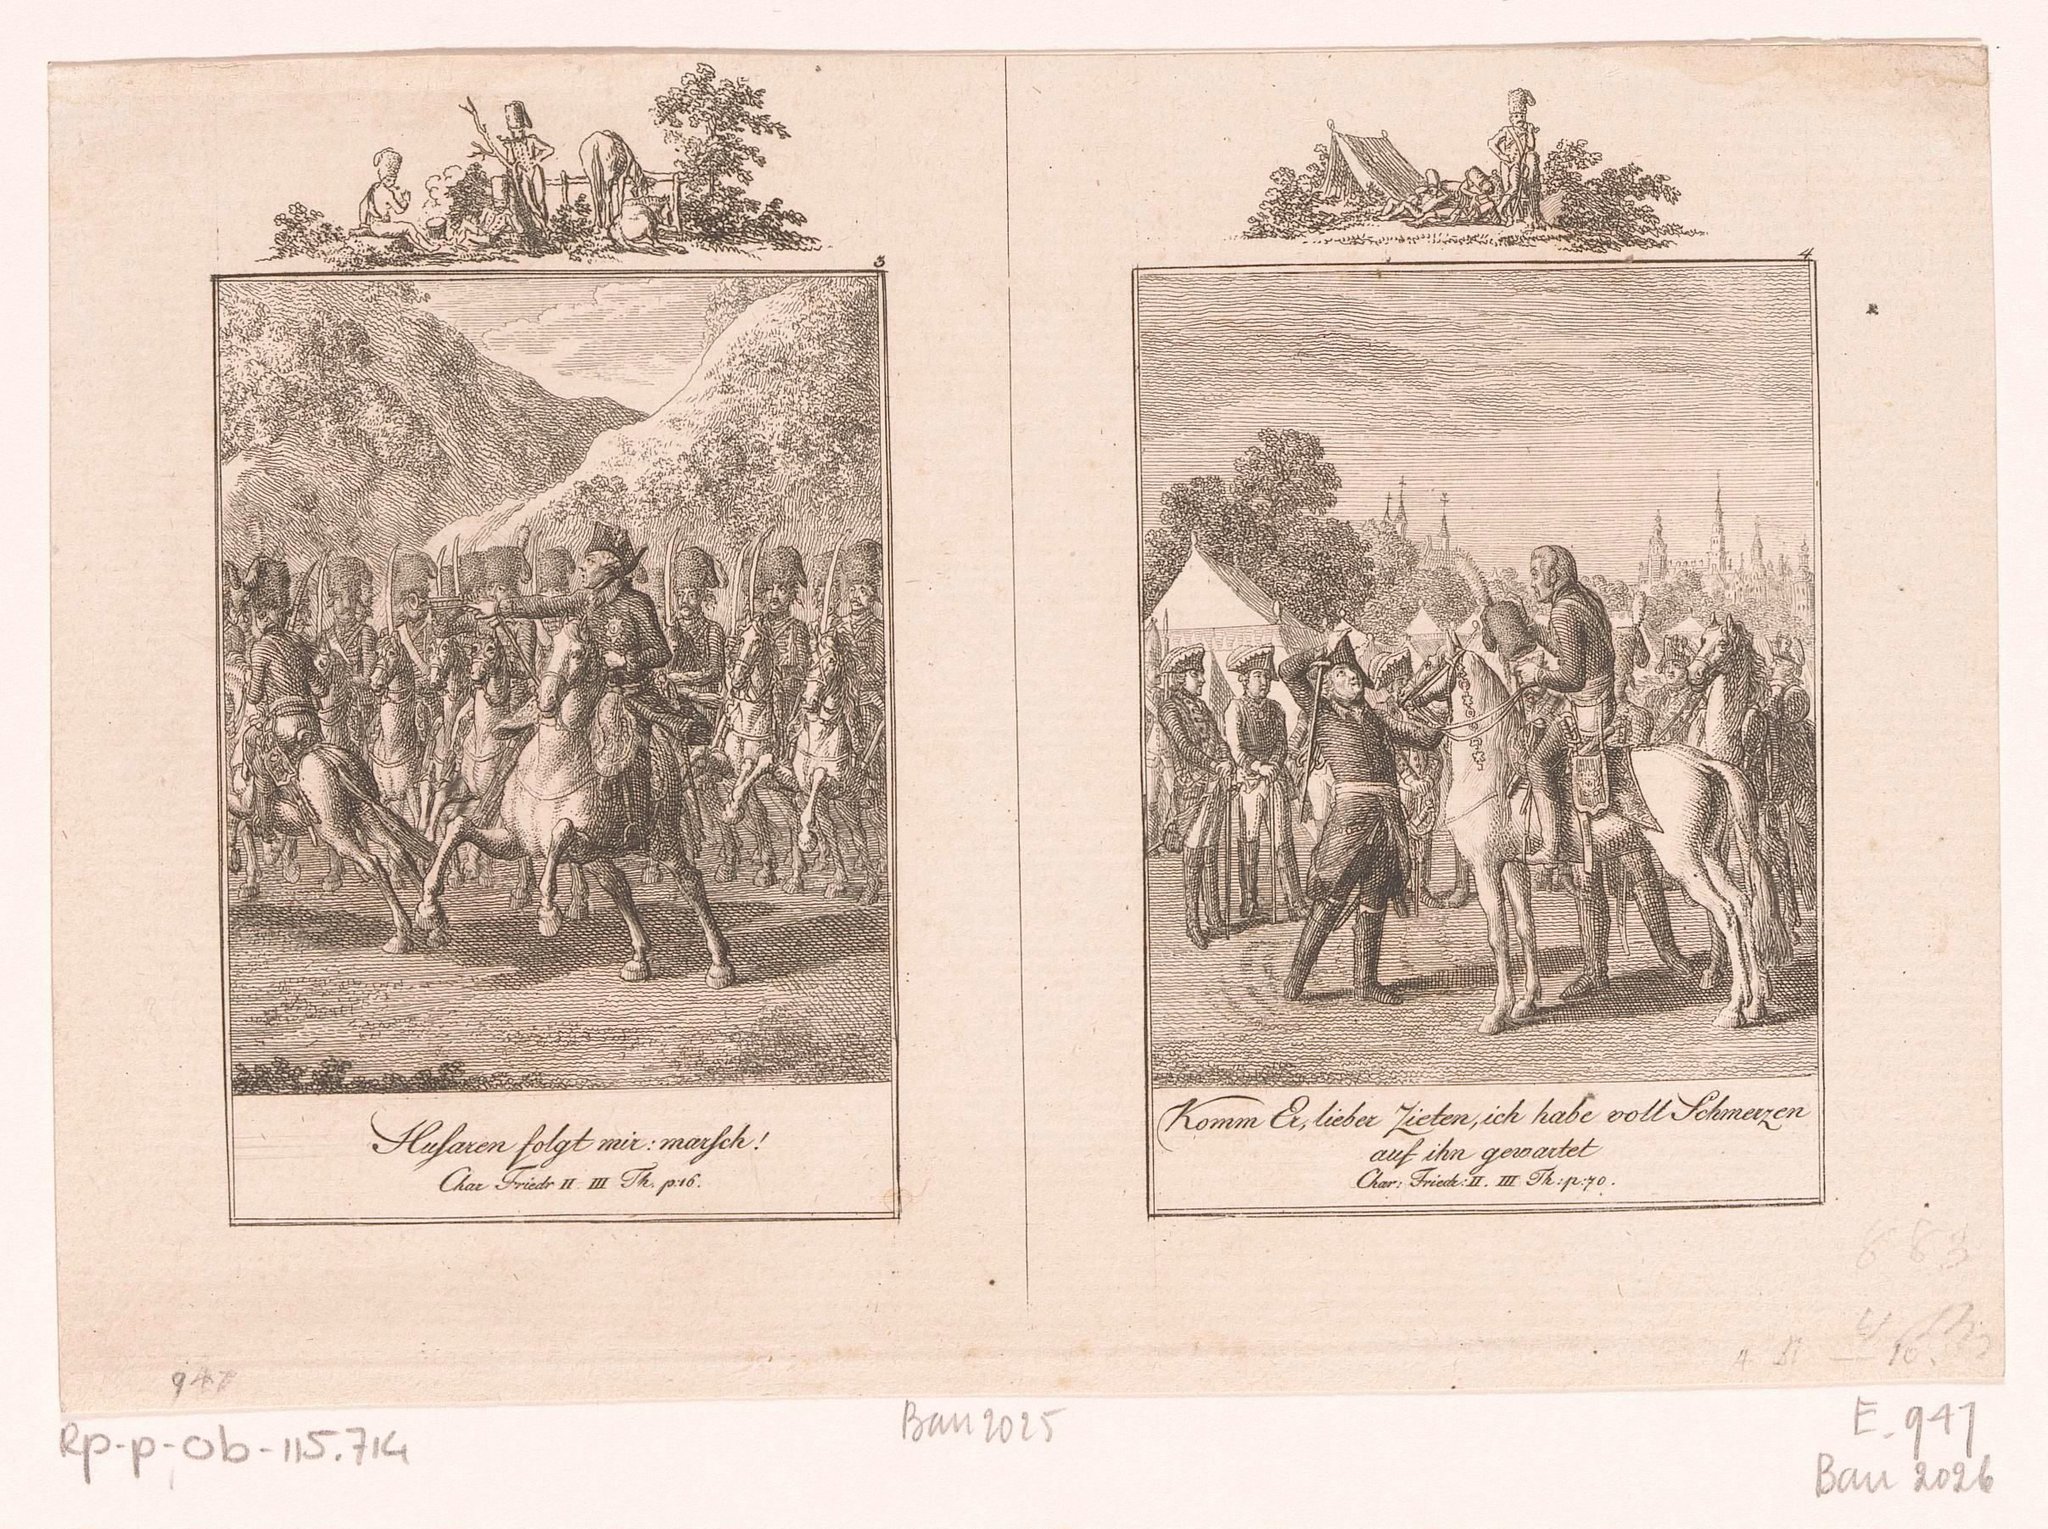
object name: print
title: Twee voorstellingen uit de anekdoten van Friedrich II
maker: daniel nikolaus chodowiecki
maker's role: draughtsman, print maker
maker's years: 1726-1801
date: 1800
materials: paper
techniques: etching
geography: berlin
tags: frederick ii (king of prussia), (military) camp with tents, charge ~ battle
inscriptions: collector's mark: Lugt 2228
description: Rechtsboven genummerd. Met onderschrift en paginaverwijzing in het Duits. In de marge zijn op schetsmatige wijze verschillende figuren geëtst.